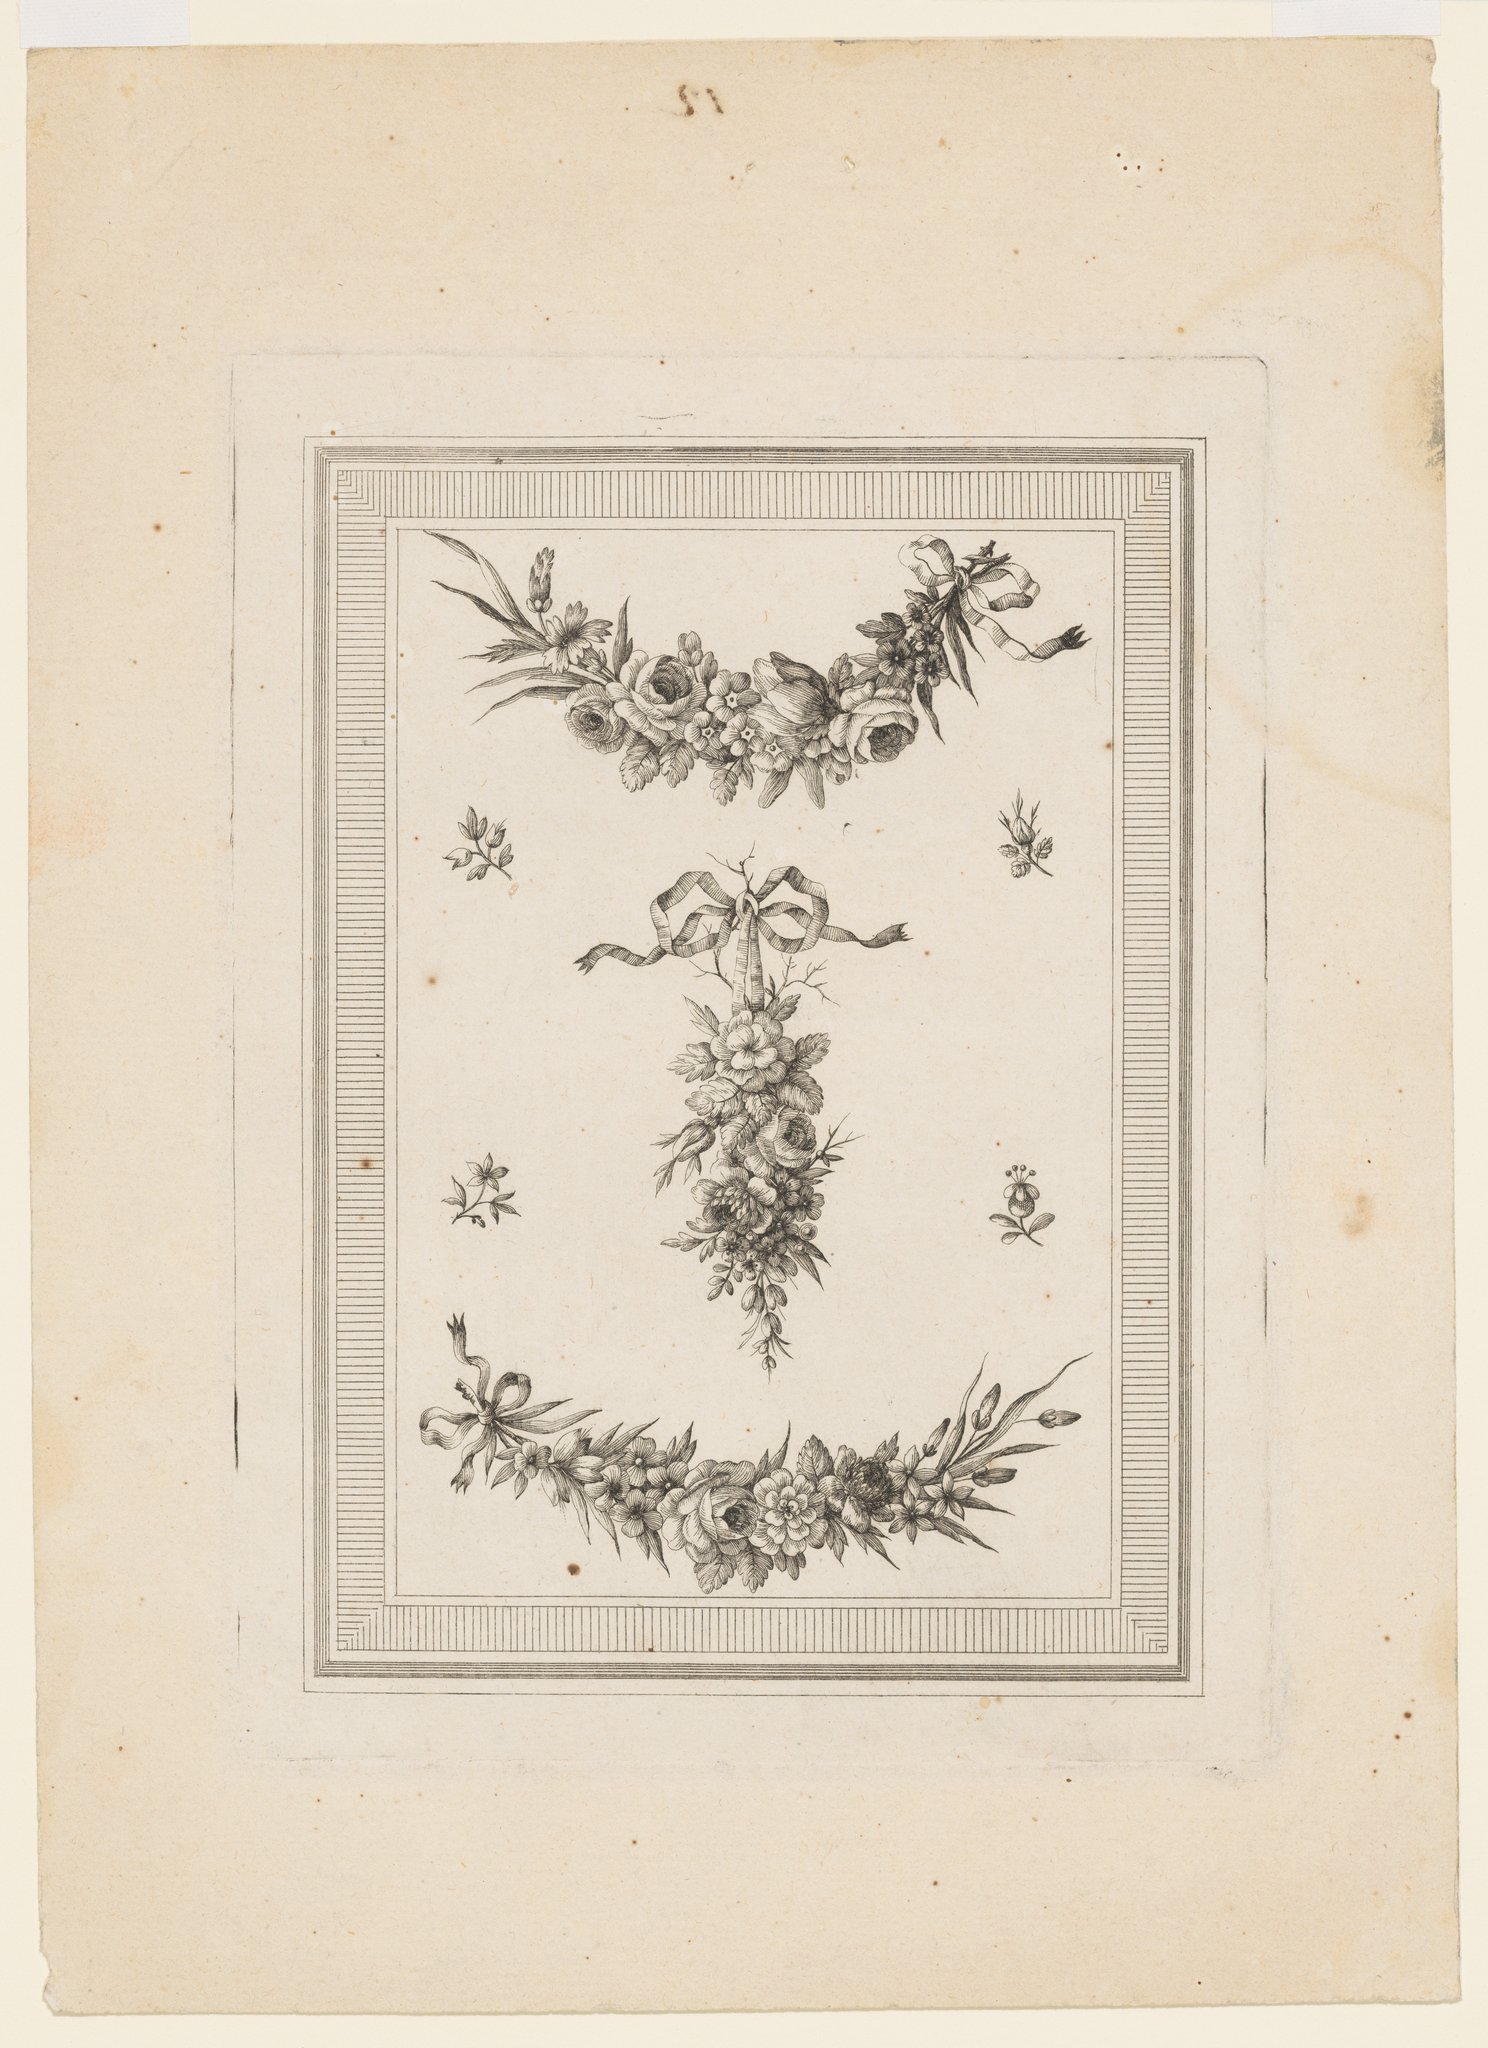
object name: print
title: Floral Decoration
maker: pierre ranson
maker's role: artist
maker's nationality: french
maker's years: 1736-1786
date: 1701-1800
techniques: etching